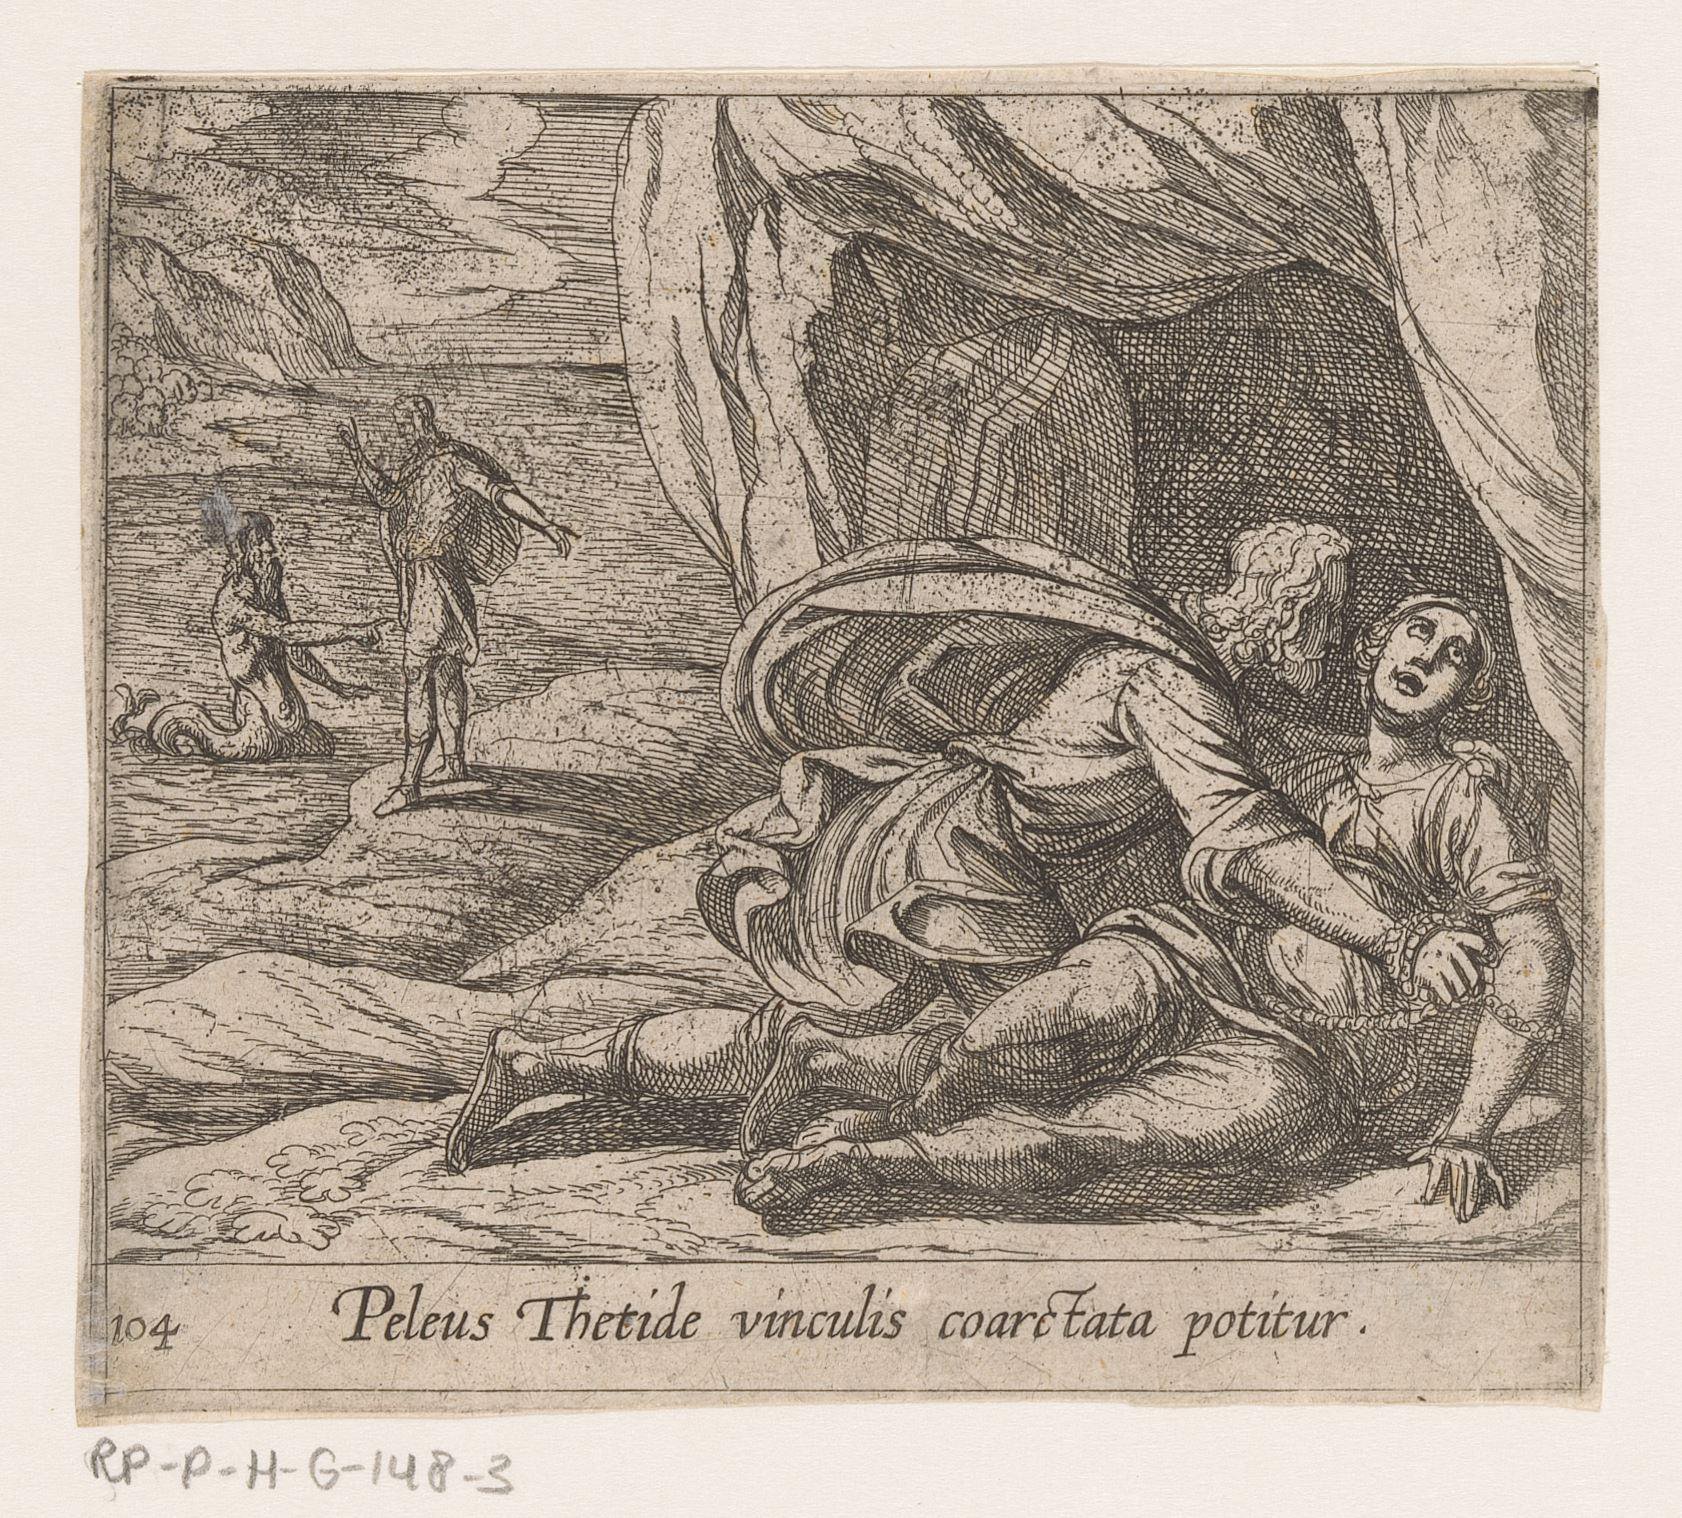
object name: print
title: Peleus Thetide vinculis coarctata potitur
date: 1606-1638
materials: paper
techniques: etching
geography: amsterdam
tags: (story of) peleus and thetis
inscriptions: collector's mark: ‘Hinloopen’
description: Deze prent maakt deel uit van een reeks van 150 prenten (+ titelprent) met voorstellingen van de Metamorfosen van Ovidius.